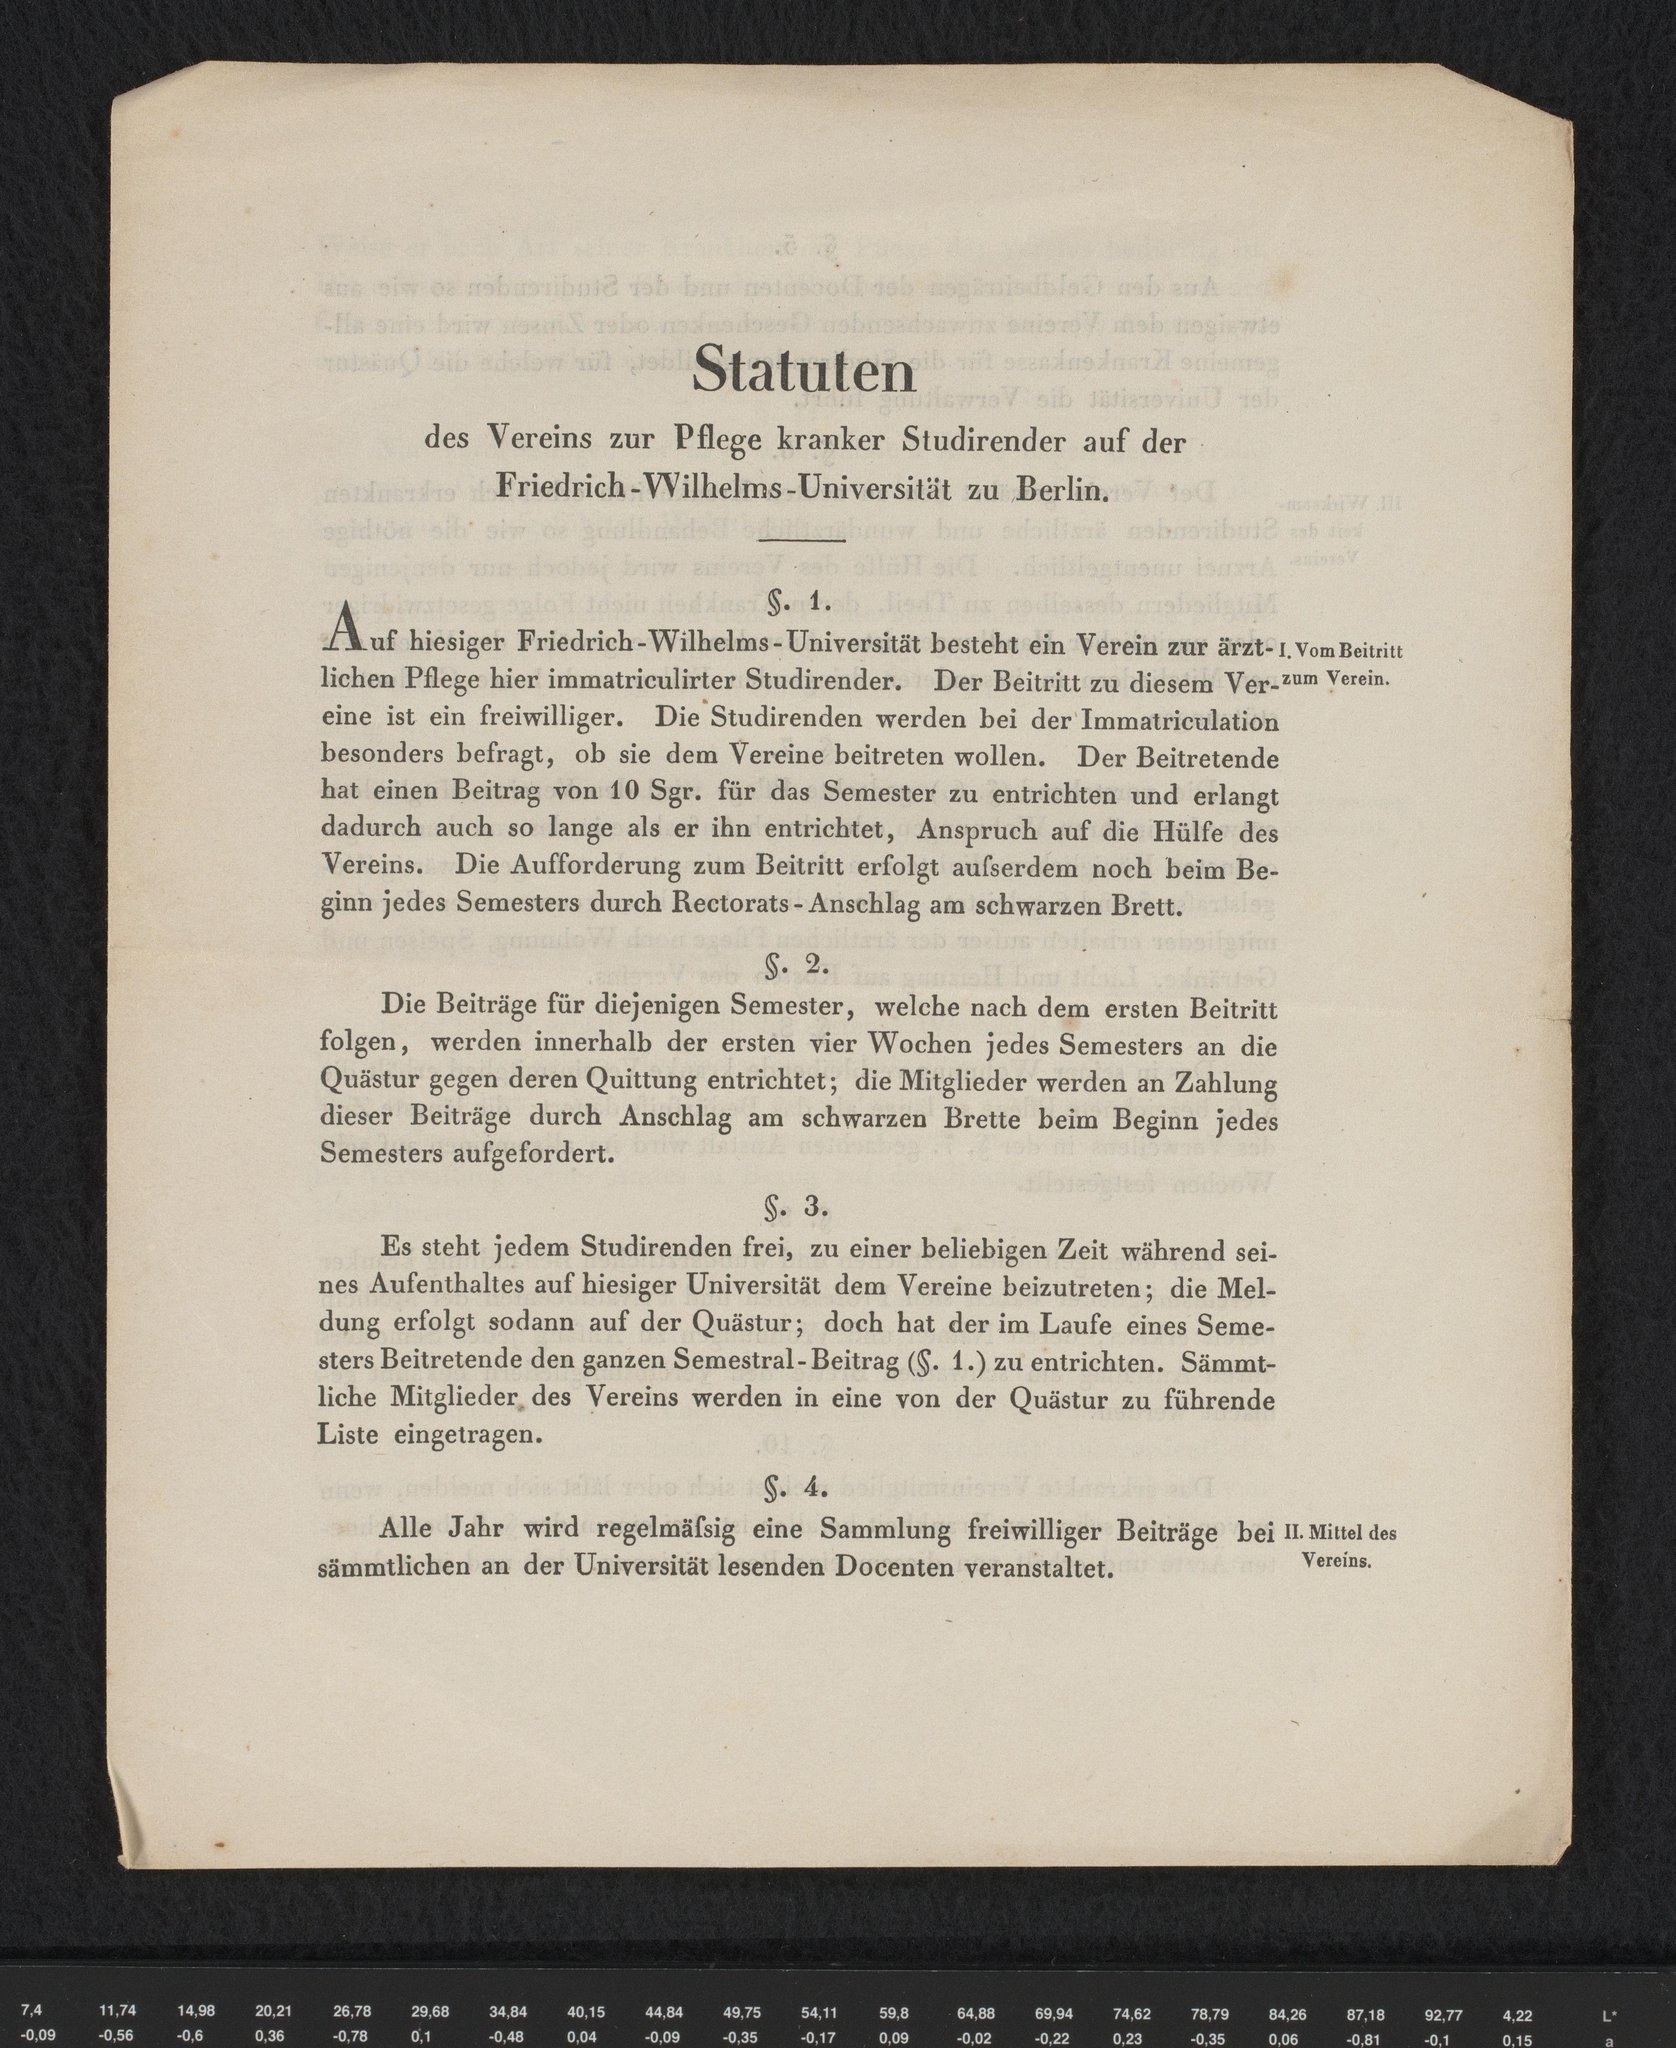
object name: text sheet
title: Statuten des Vereins zur Pflege kranker Studirender auf der Friedrich-Wilhelms-Universität zu Berlin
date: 1828-1920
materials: paper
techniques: letterpress printing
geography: berlin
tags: swellengrebel, familie, friedrich-wilhelms-universität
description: Statuten van de Vereniging voor de Zorg voor Zieke Studenten aan de Friedrich-Wilhelms-Universiteit te Berlijn. Dubbelgevouwen blad, bedrukt op alle vier zijden met de 20 genummerde regels in het Duits. Onduidelijk op welk lid van de familie Swellengrebel dit document betrekking heeft.